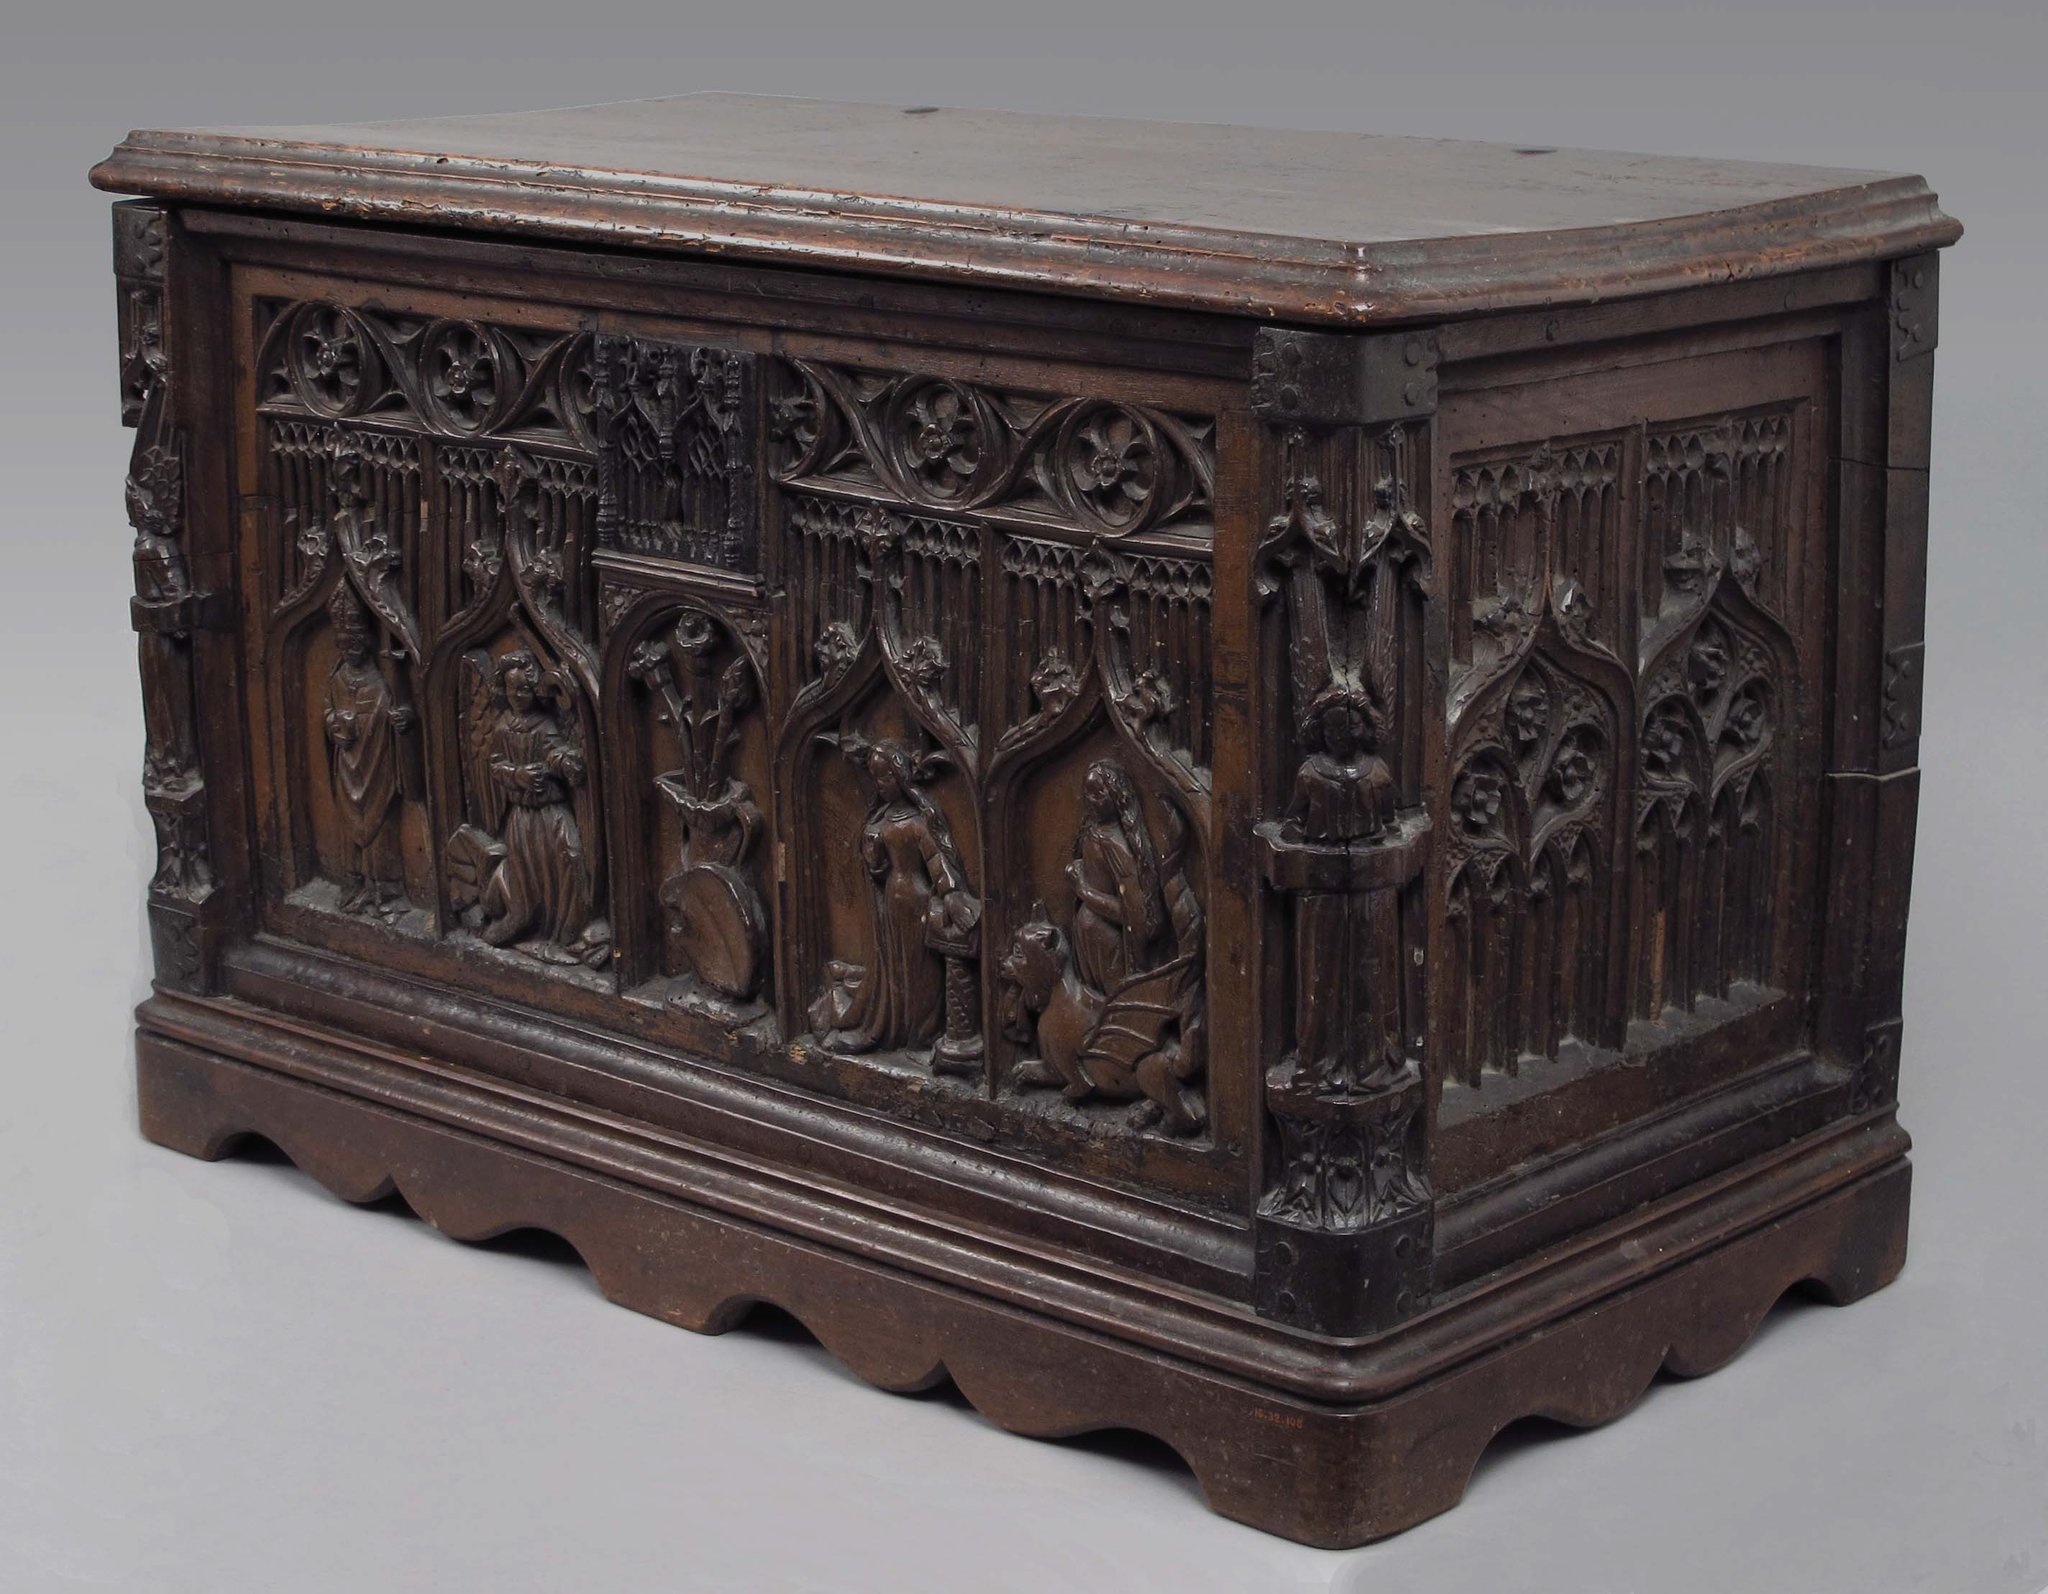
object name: chest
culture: french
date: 1467-1500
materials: iron, wood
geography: france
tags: human figures,cross